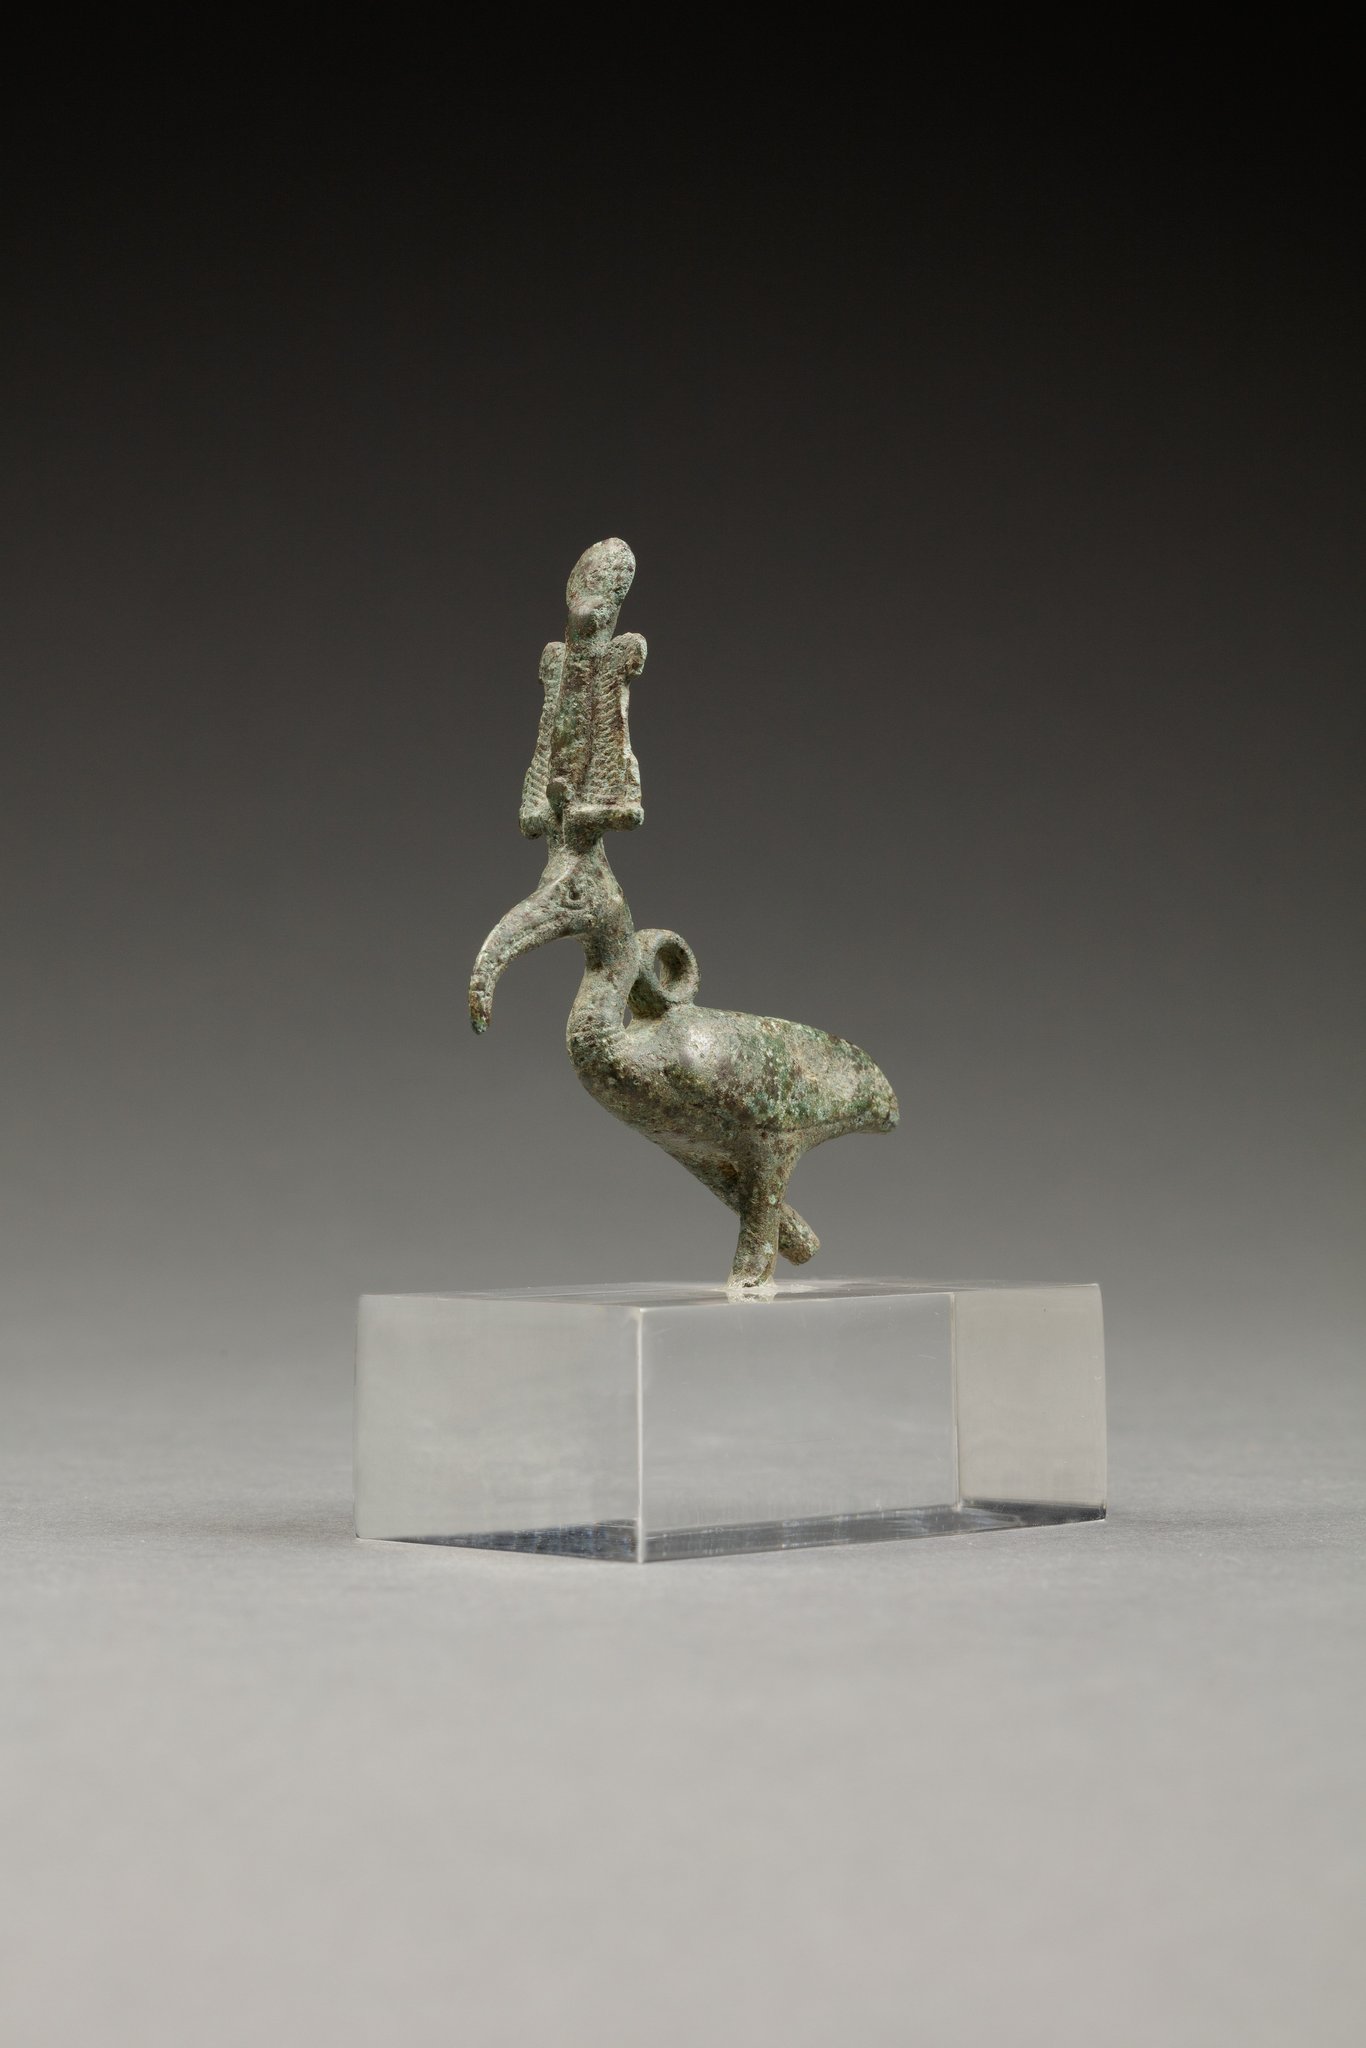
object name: figure of an ibis wearing an atef crown, with a suspension loop, pendant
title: Pendant of an ibis wearing an atef crown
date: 664-630 BCE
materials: metal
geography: egypt